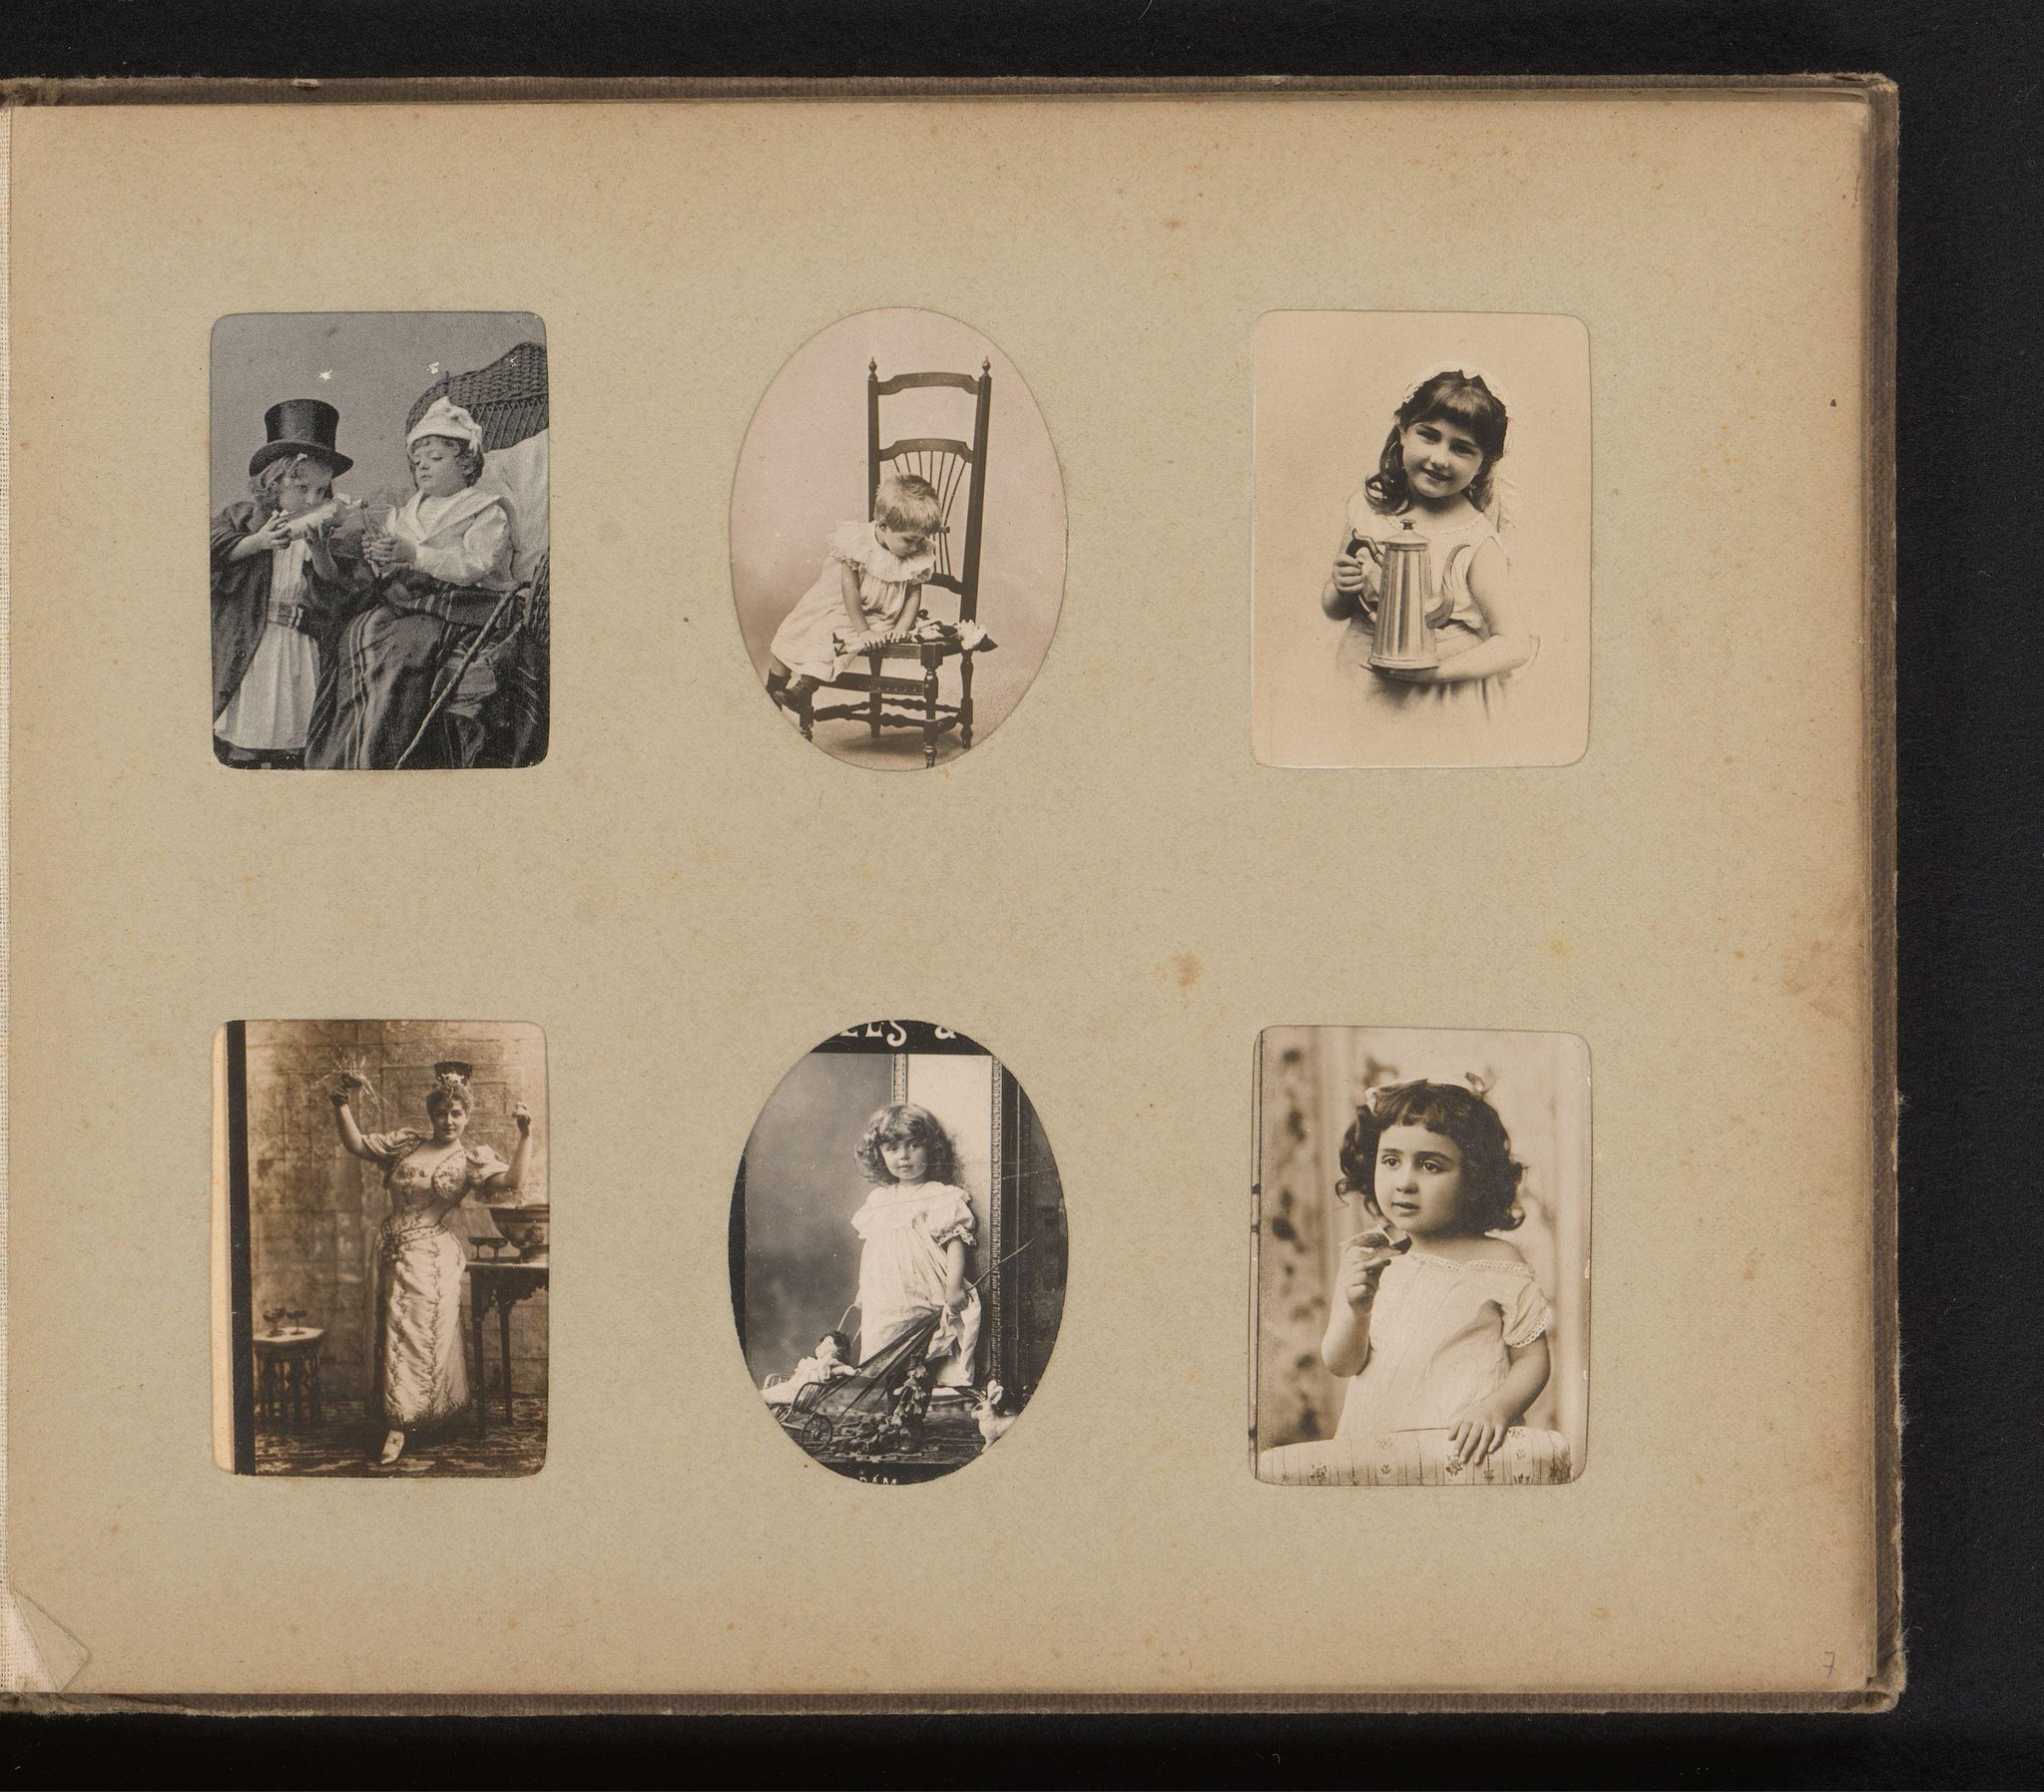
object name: album leaf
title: Portretten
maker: Anonymous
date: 1890-1900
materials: cardboard, paper, photographic support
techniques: photograph, gelatin silver print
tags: coffee-pot, adult woman, child (at home)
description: Vijf portretten van kinderen, waaronder één van een meisje met een koffiekan, en één portret van een vrouw met een waaier. Deze pagina is deel van een album.